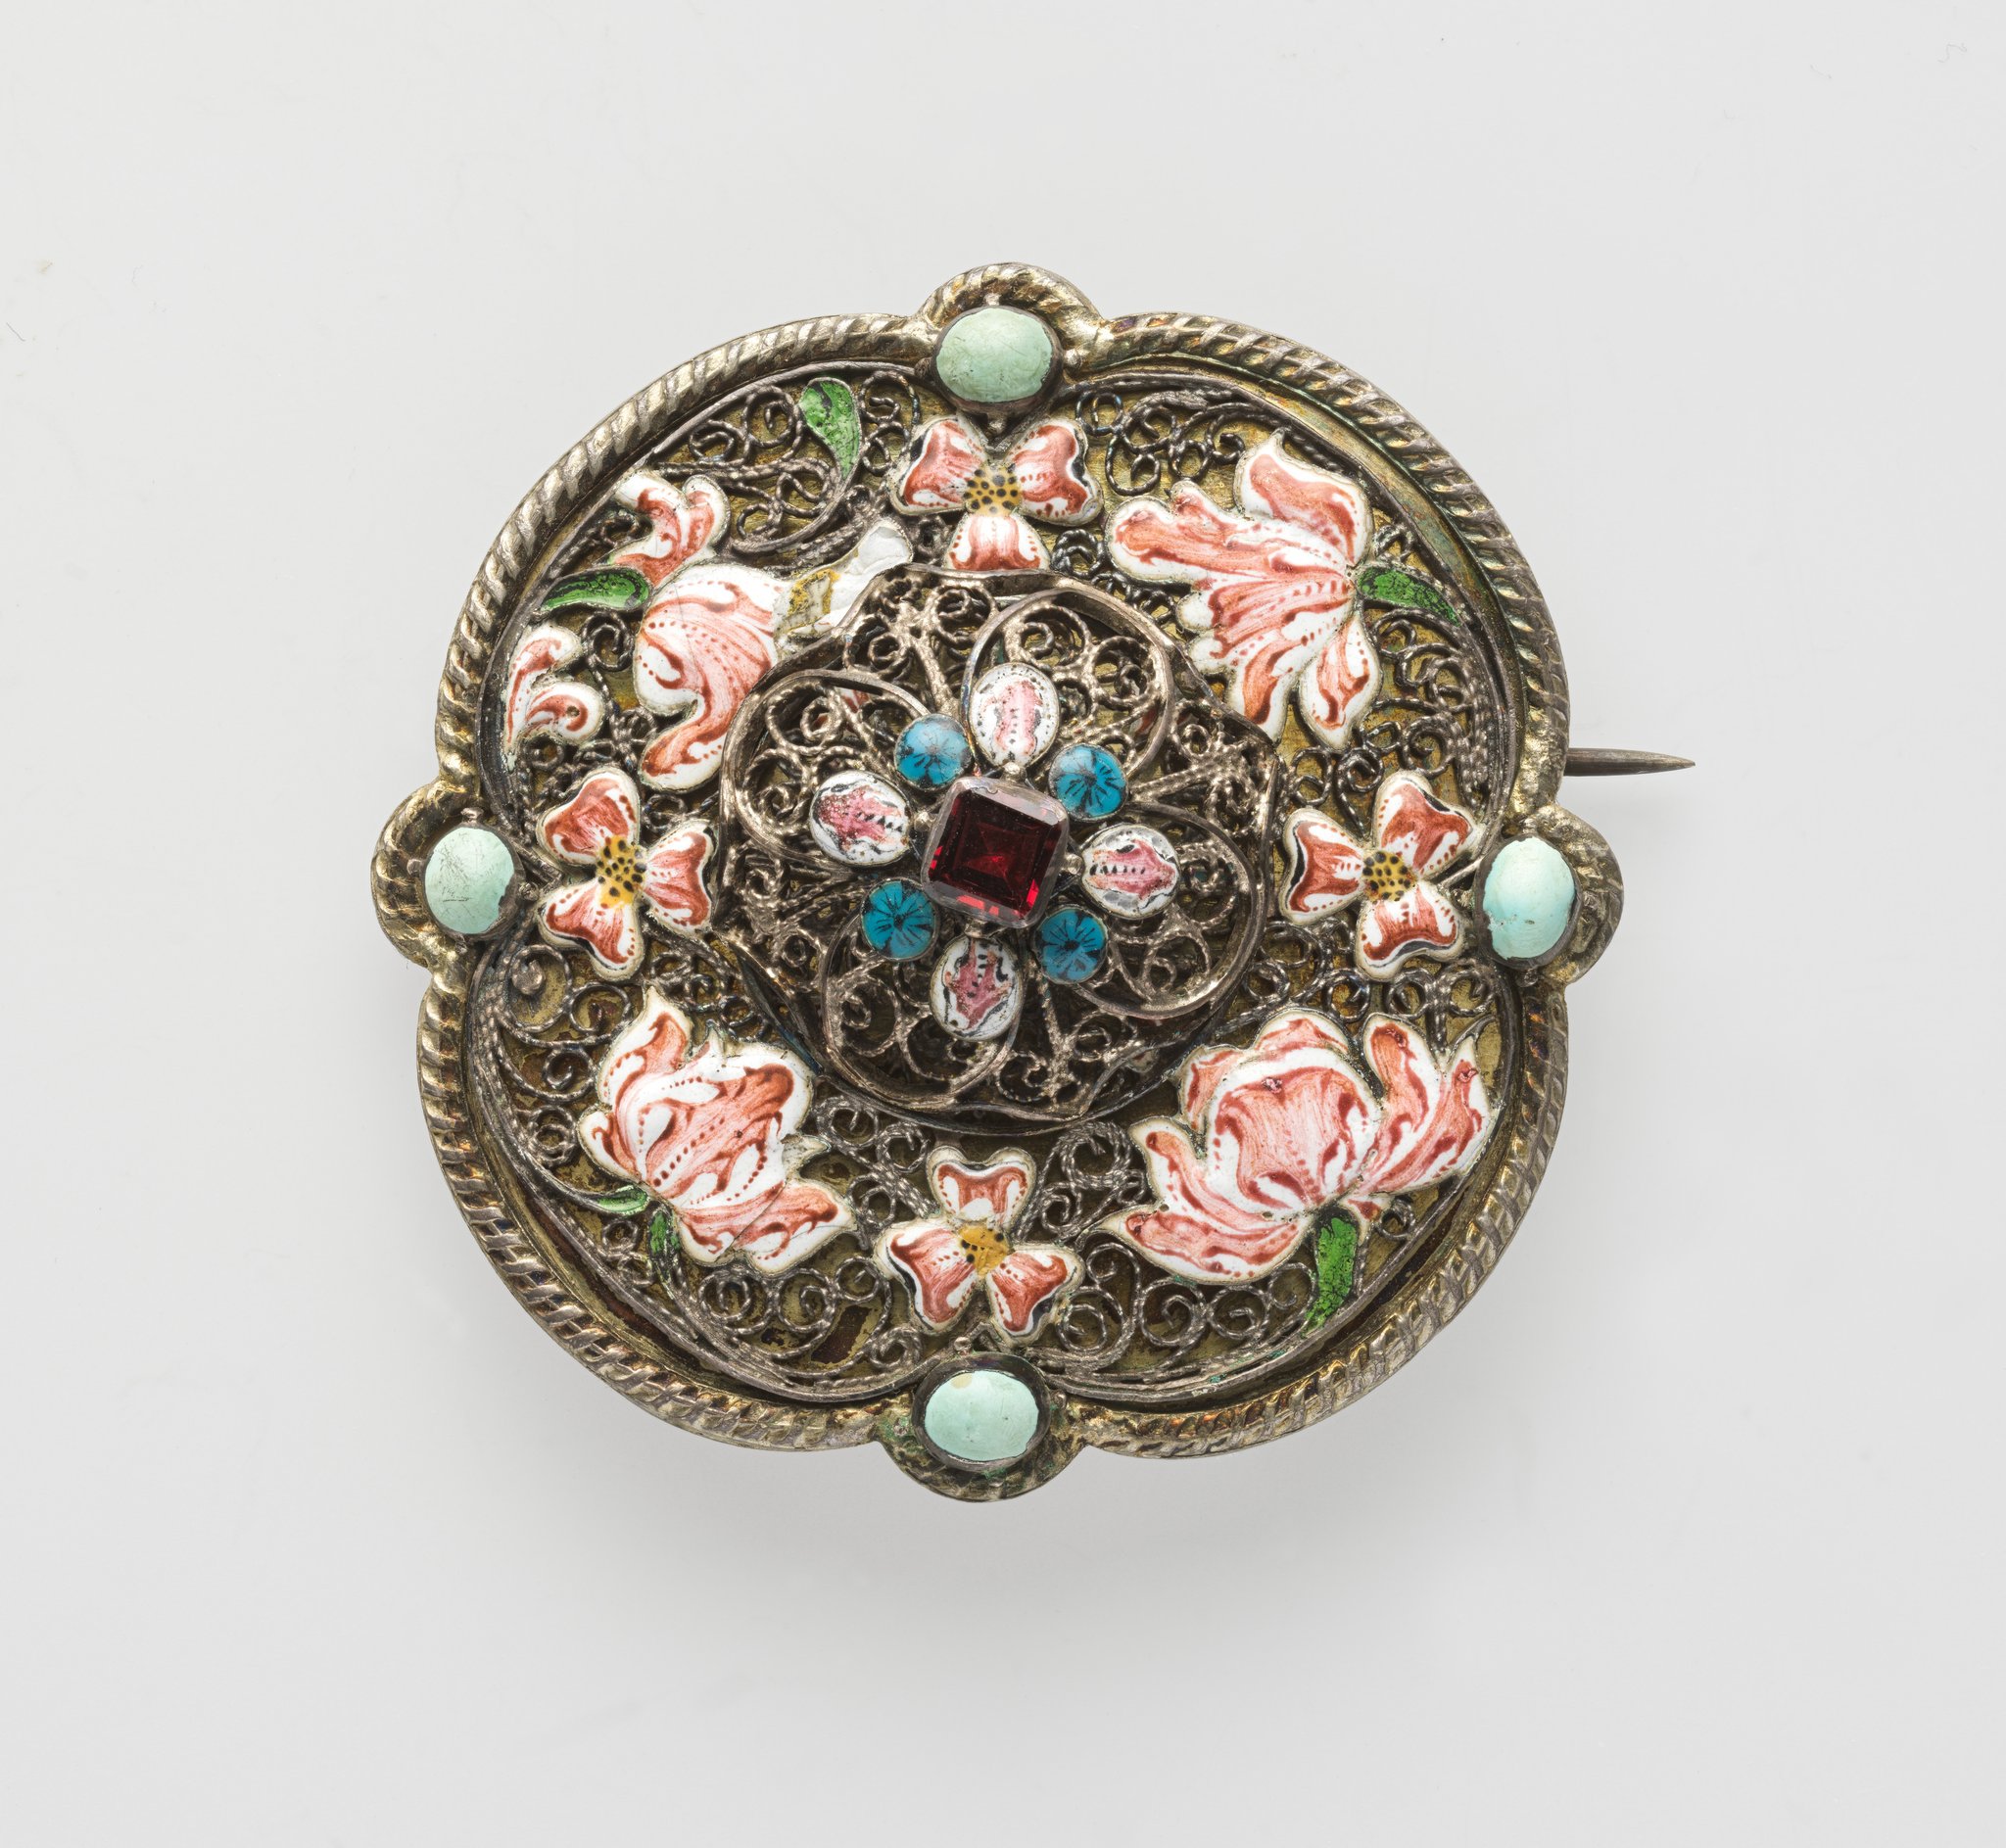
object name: clasp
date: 1701-1900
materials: silver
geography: iran